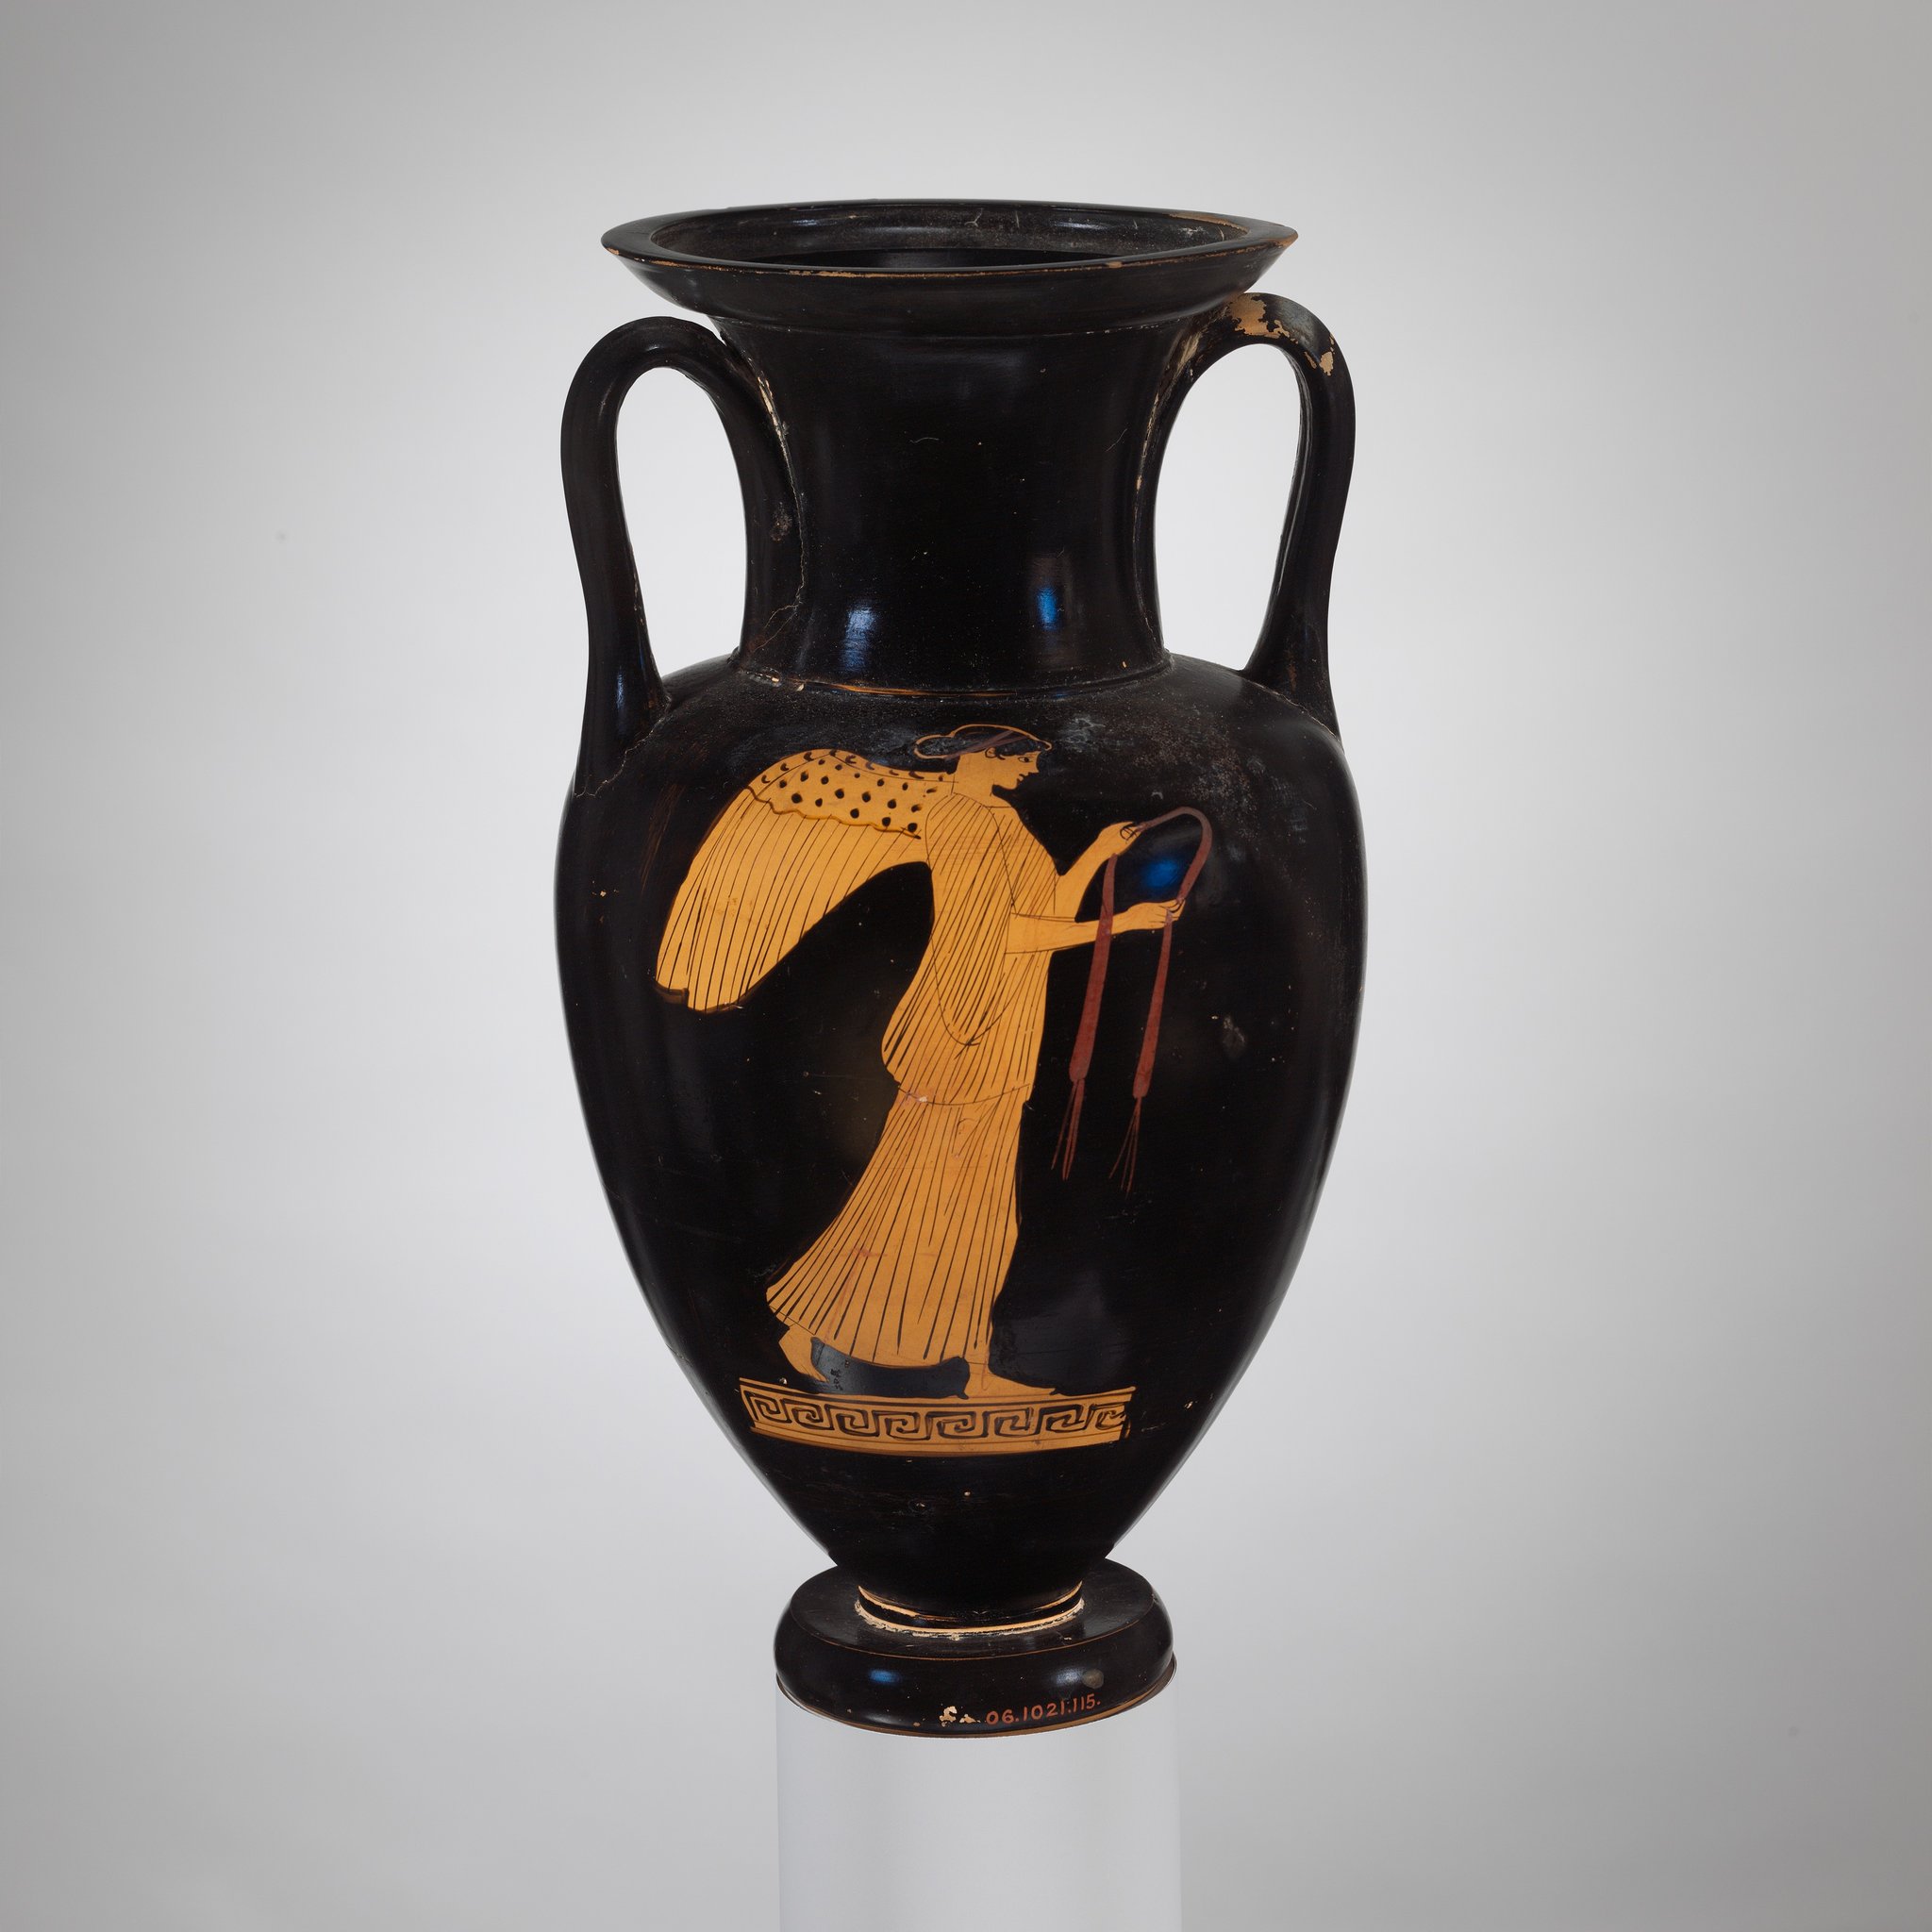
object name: nolan neck amphora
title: Terracotta Nolan neck-amphora (jar)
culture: greek, attic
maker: painter of london e 342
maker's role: artist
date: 460 BCE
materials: terracotta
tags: men,nike